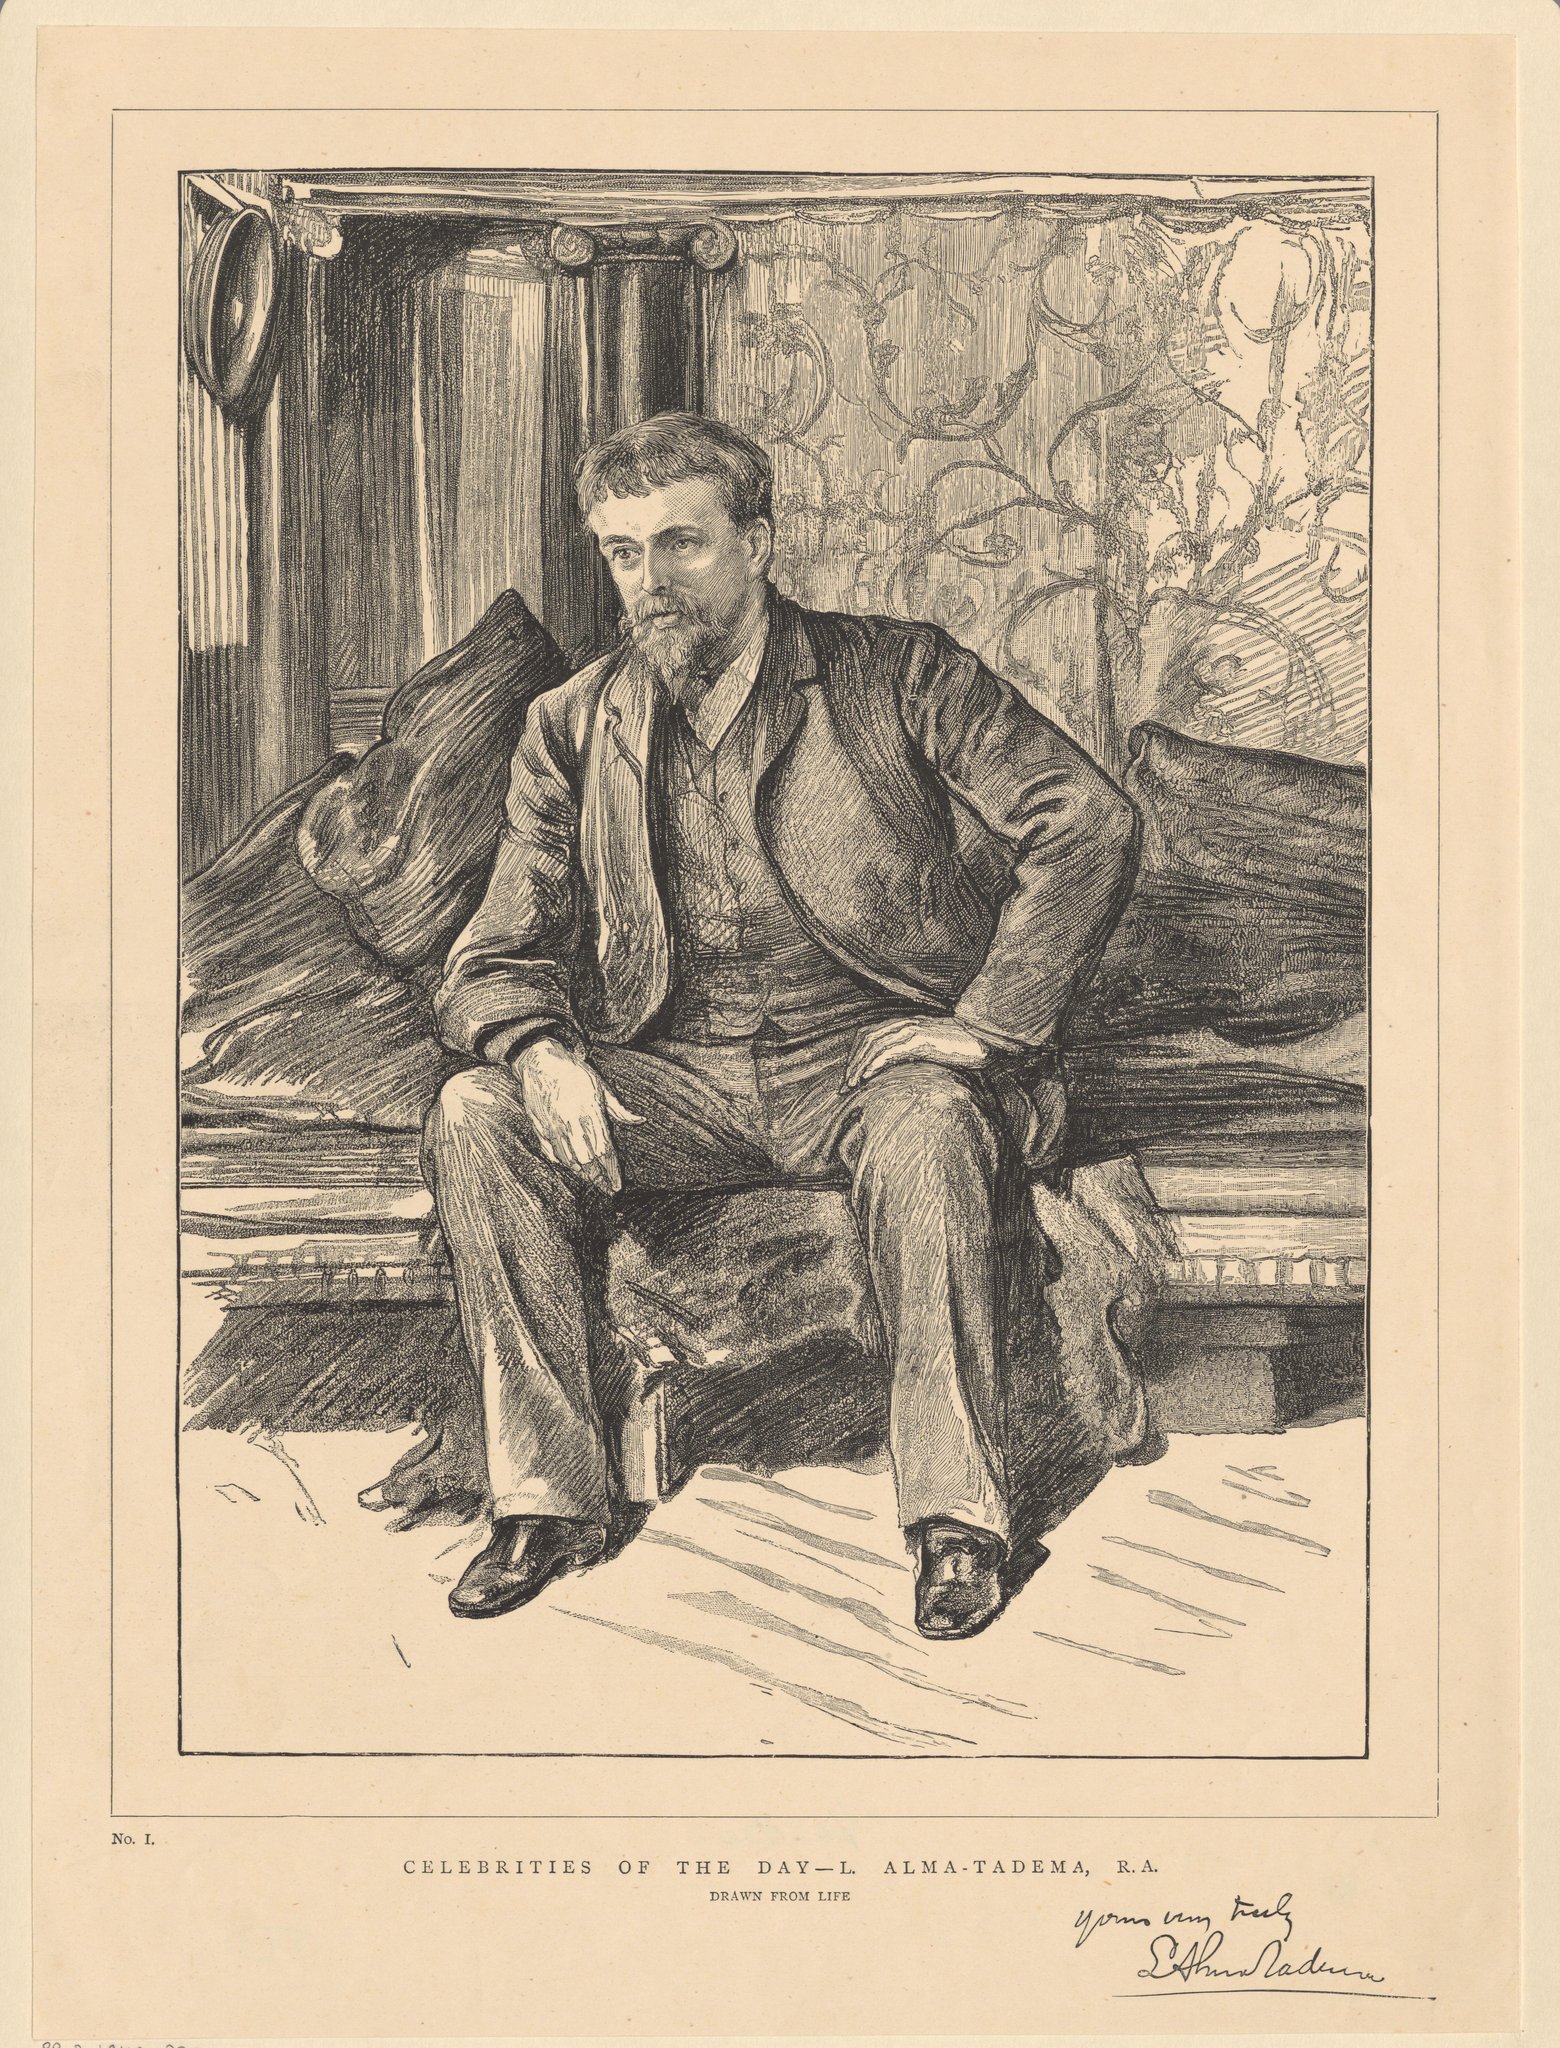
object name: print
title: Portret van Lourens Alma Tadema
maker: Anonymous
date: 1883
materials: paper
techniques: letterpress printing, engraving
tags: draughtsman, lourens alma tadema, historical persons, portrait, self-portrait of painter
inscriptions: collector's mark: Lugt 2228, collector's mark: Lugt 2760